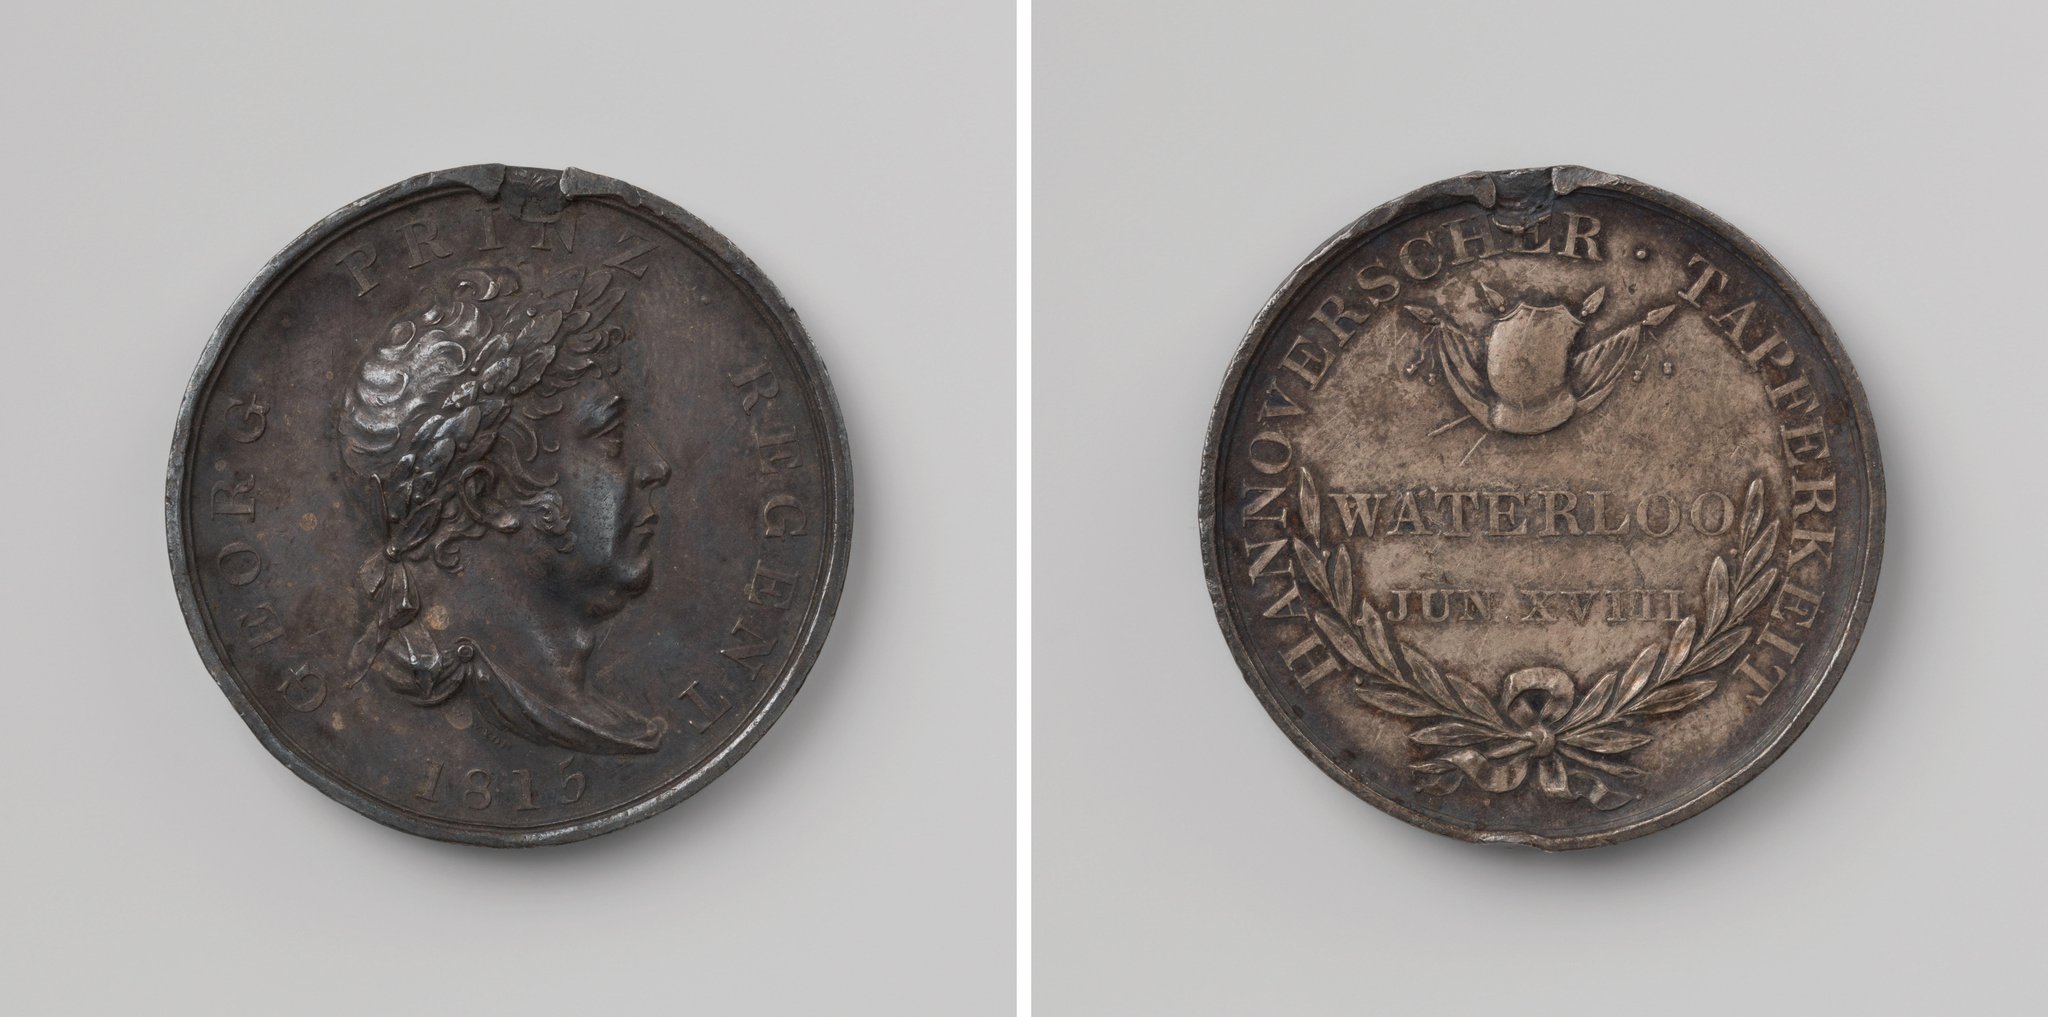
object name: insignia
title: Slag bij Waterloo, draagteken uitgereikt aan soldaat Berend Rammelkamp, Landw. in het bataillon Bentheim, ter ere van prins-regent George, keurvorst van Hannover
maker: william wyon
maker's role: medailleur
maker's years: 1795-1851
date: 1815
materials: silver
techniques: engraving, striking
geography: london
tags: george iv (koning van het verenigd koninkrijk), waterloo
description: Zilveren draagteken met afgebroken draagoog. Voorzijde: borststuk man met lauwerkrans binnen omschrift. Keerzijde: harnas tussen twee vaandels en twee lansen boven opschrift binnen lauwerkrans en omschrift; randschrift